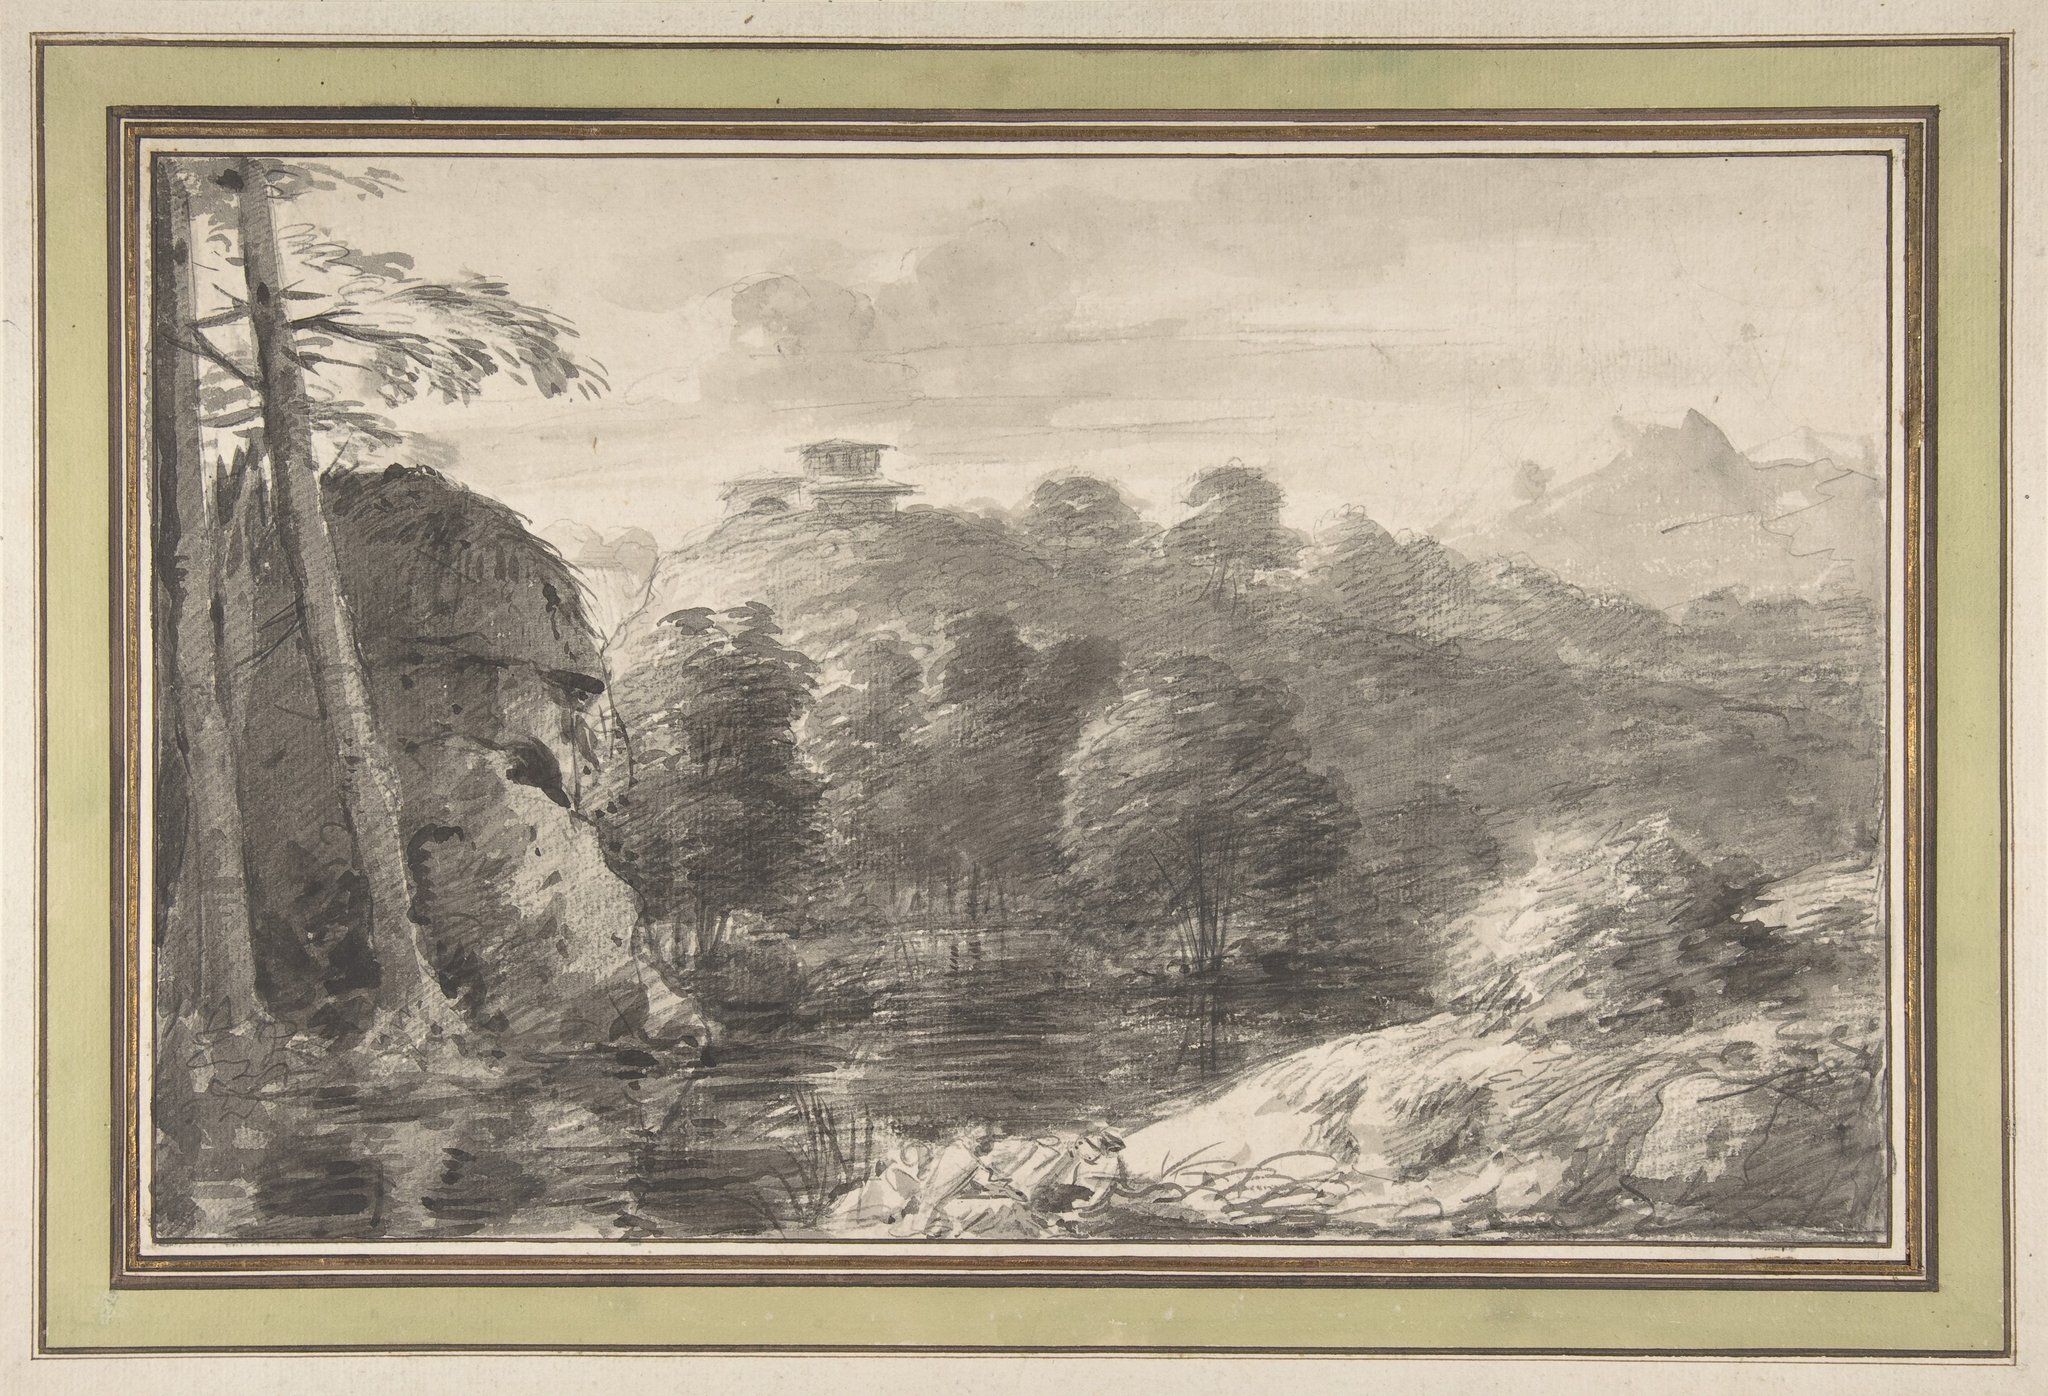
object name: drawing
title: Italian Landscape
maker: anonymous, french, 18th century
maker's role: artist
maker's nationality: french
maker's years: 1700-1800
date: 1701-1800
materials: chalk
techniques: brush, wash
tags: landscapes,trees